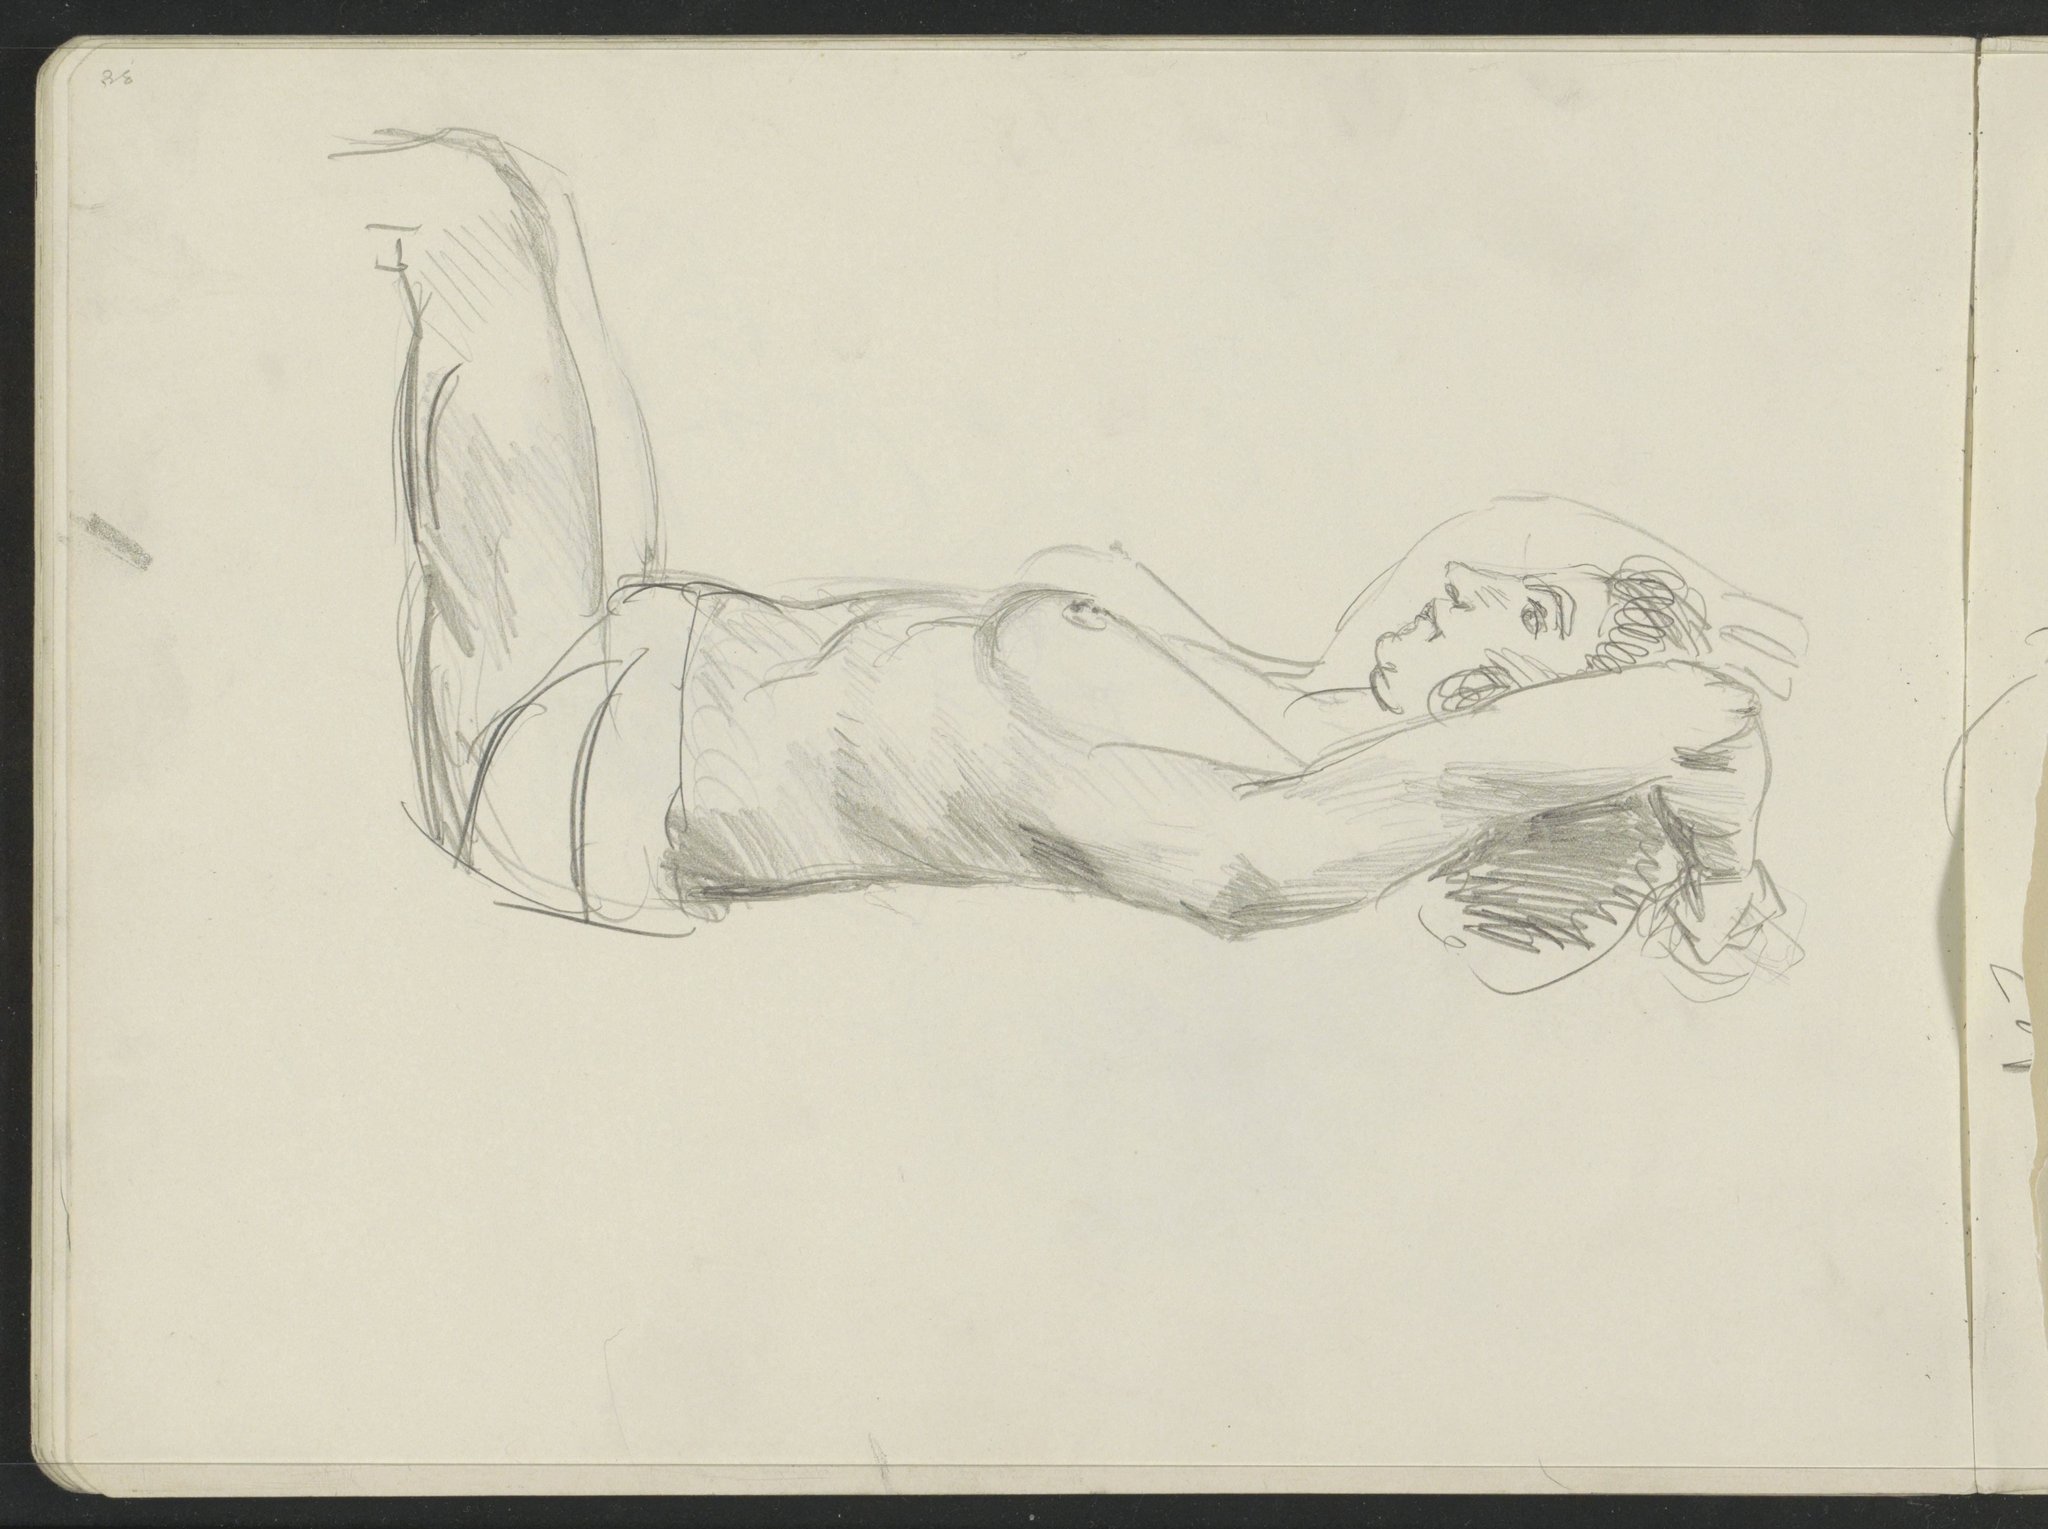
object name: sketchbook leaf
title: Zittende vrouw met ontbloot bovenlijf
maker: isaac israels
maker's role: draughtsman, painter, print maker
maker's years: 1865-1934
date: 1915-1934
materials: paper, pencil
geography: the hague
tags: the (nude) human figure; 'corpo humano' (ripa) - aa - female human figure (+ sitting), hairdress - aa - ~ women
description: Ze is bezig met haar kapsel. Blad 25 verso uit schetsboek XVII met 31 bladen.